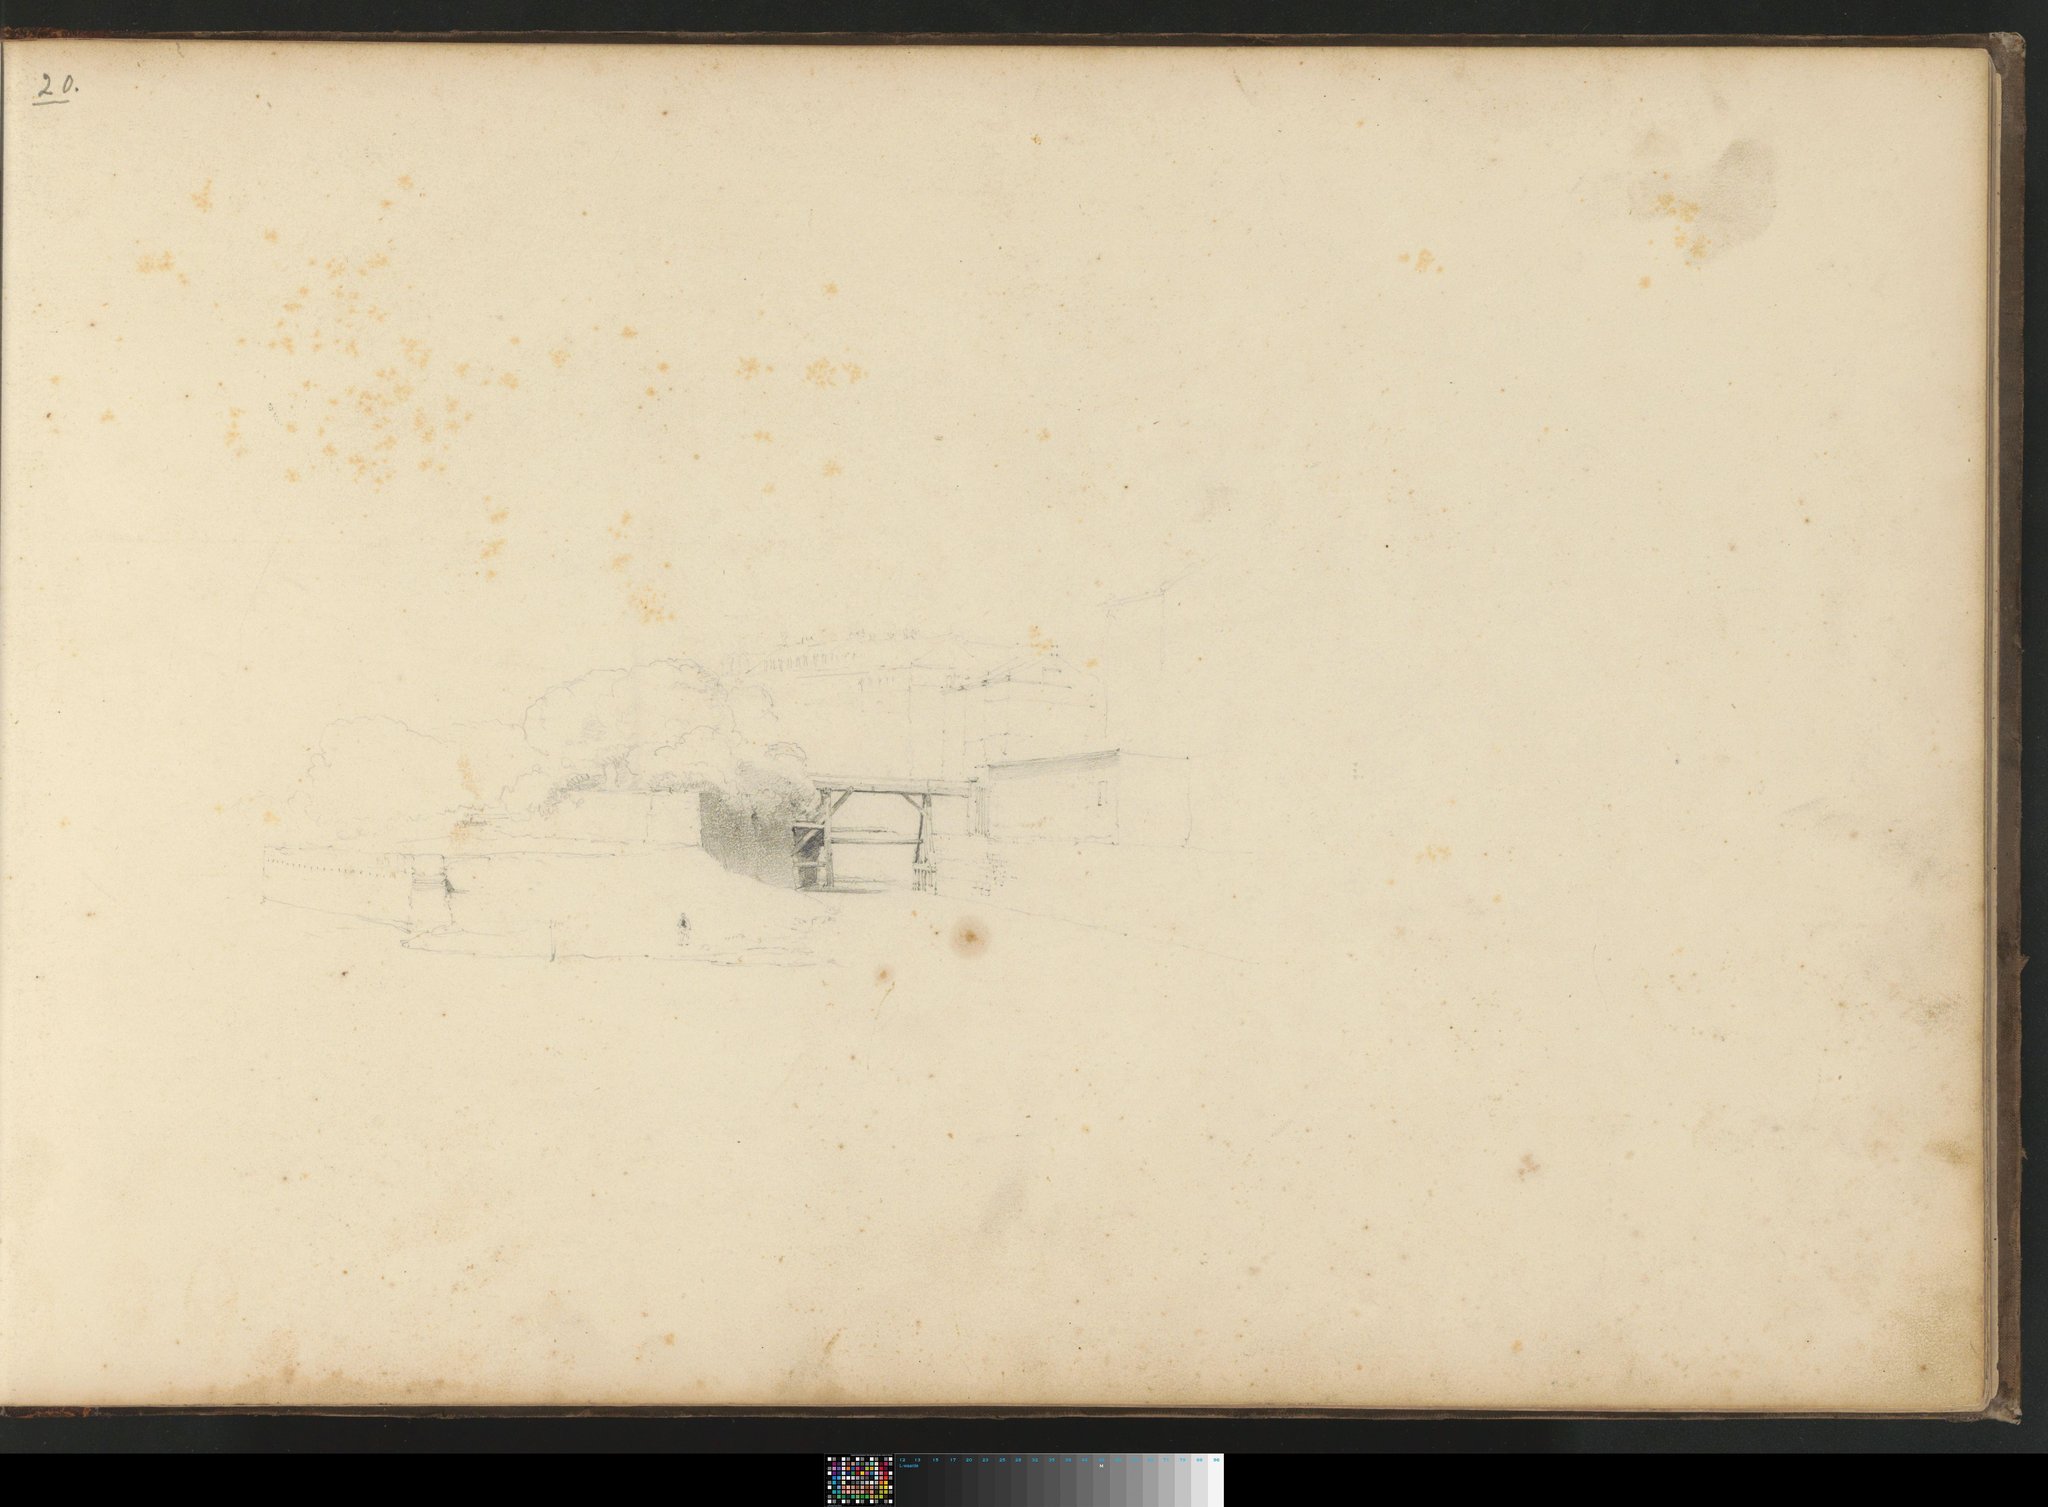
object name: sketchbook leaf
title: Steiger bij een kademuur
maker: kasparus karsen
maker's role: draughtsman, painter, print maker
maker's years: 1810-1896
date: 1820-1896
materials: paper, pencil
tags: quay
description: Op de achtergrond een stad. Blad 20 recto uit een schetsboek met 68 bladen.